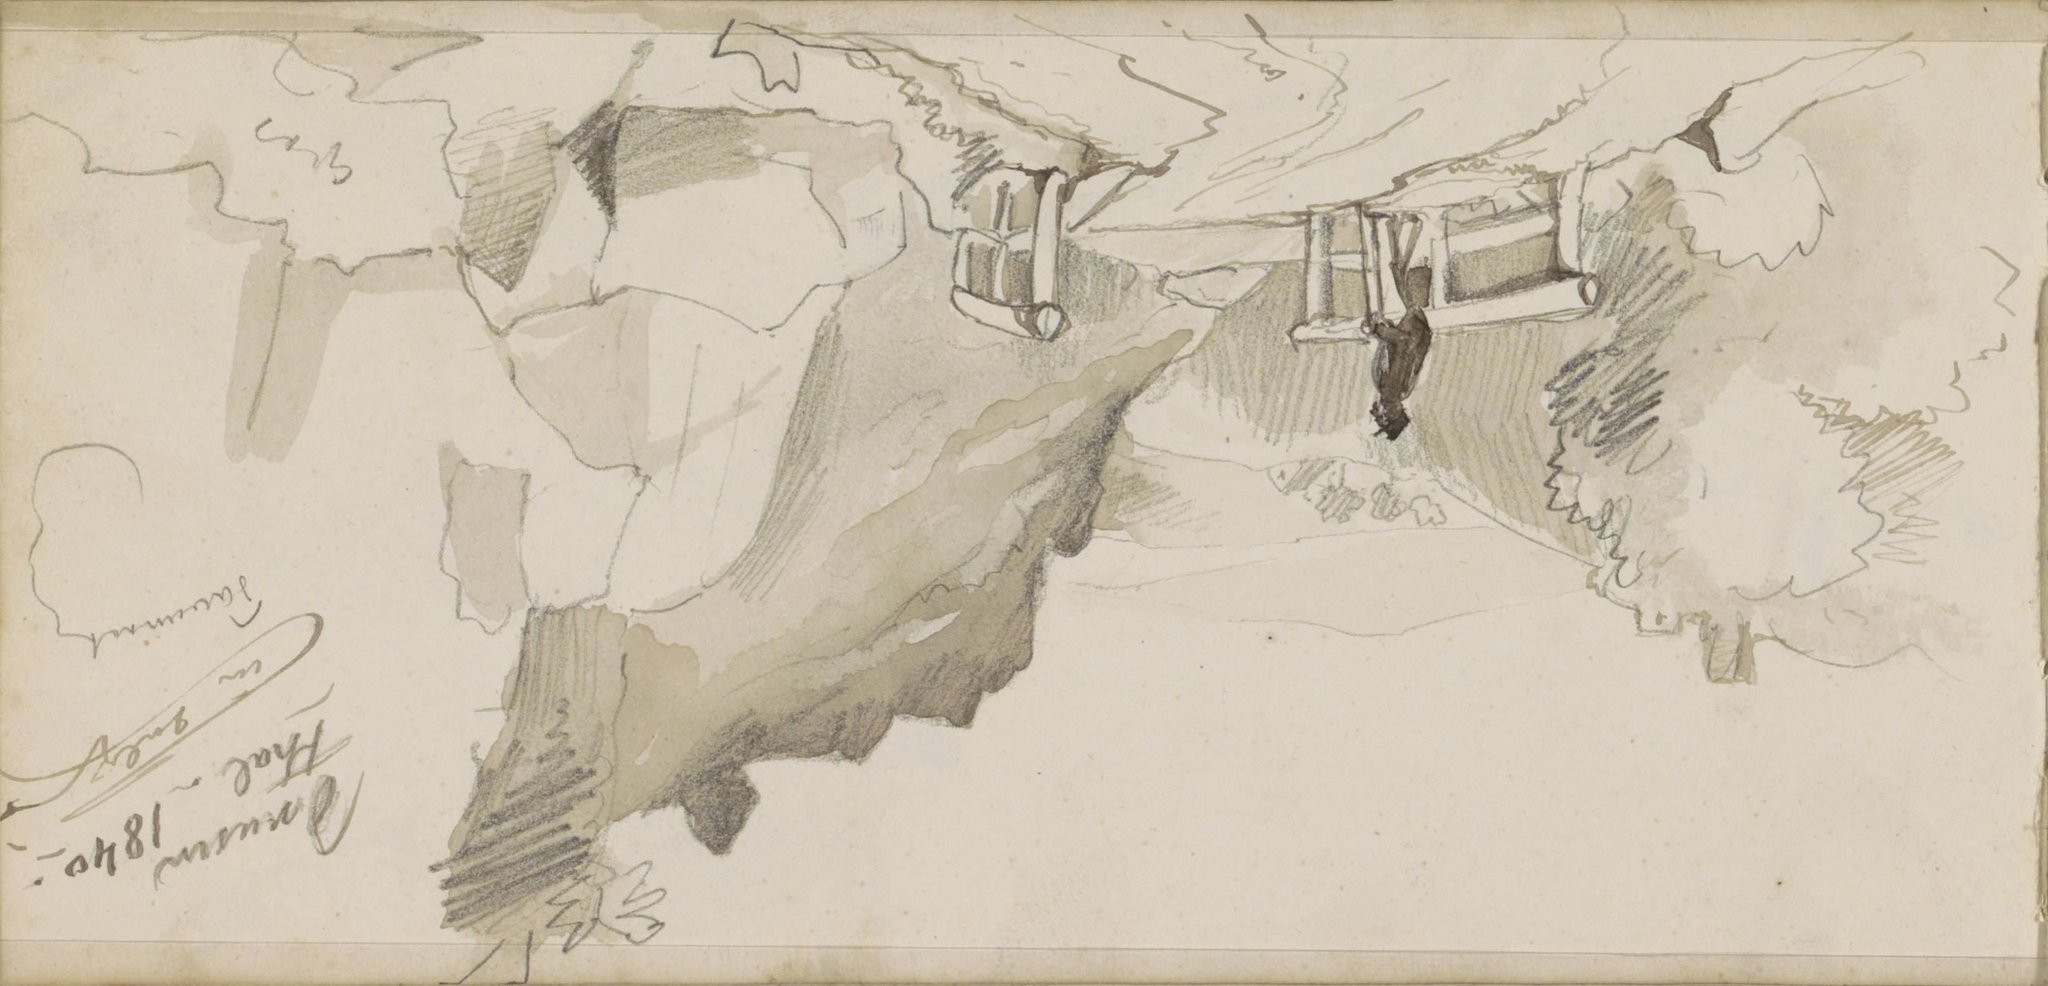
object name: sketchbook leaf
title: Man uitkijkend over een dal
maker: johannes tavenraat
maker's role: draughtsman, painter, print maker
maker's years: 1809-1881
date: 1807-1840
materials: ink, paper, pencil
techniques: brush, pen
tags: dale, valley, landscapes (+ landscape with figures, staffage)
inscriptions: signature: ‘Tavenraat’, date and inscription: ‘[...]/Thal 1840/ in July -’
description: Blad 54 verso uit een schetsboek met 63 bladen.